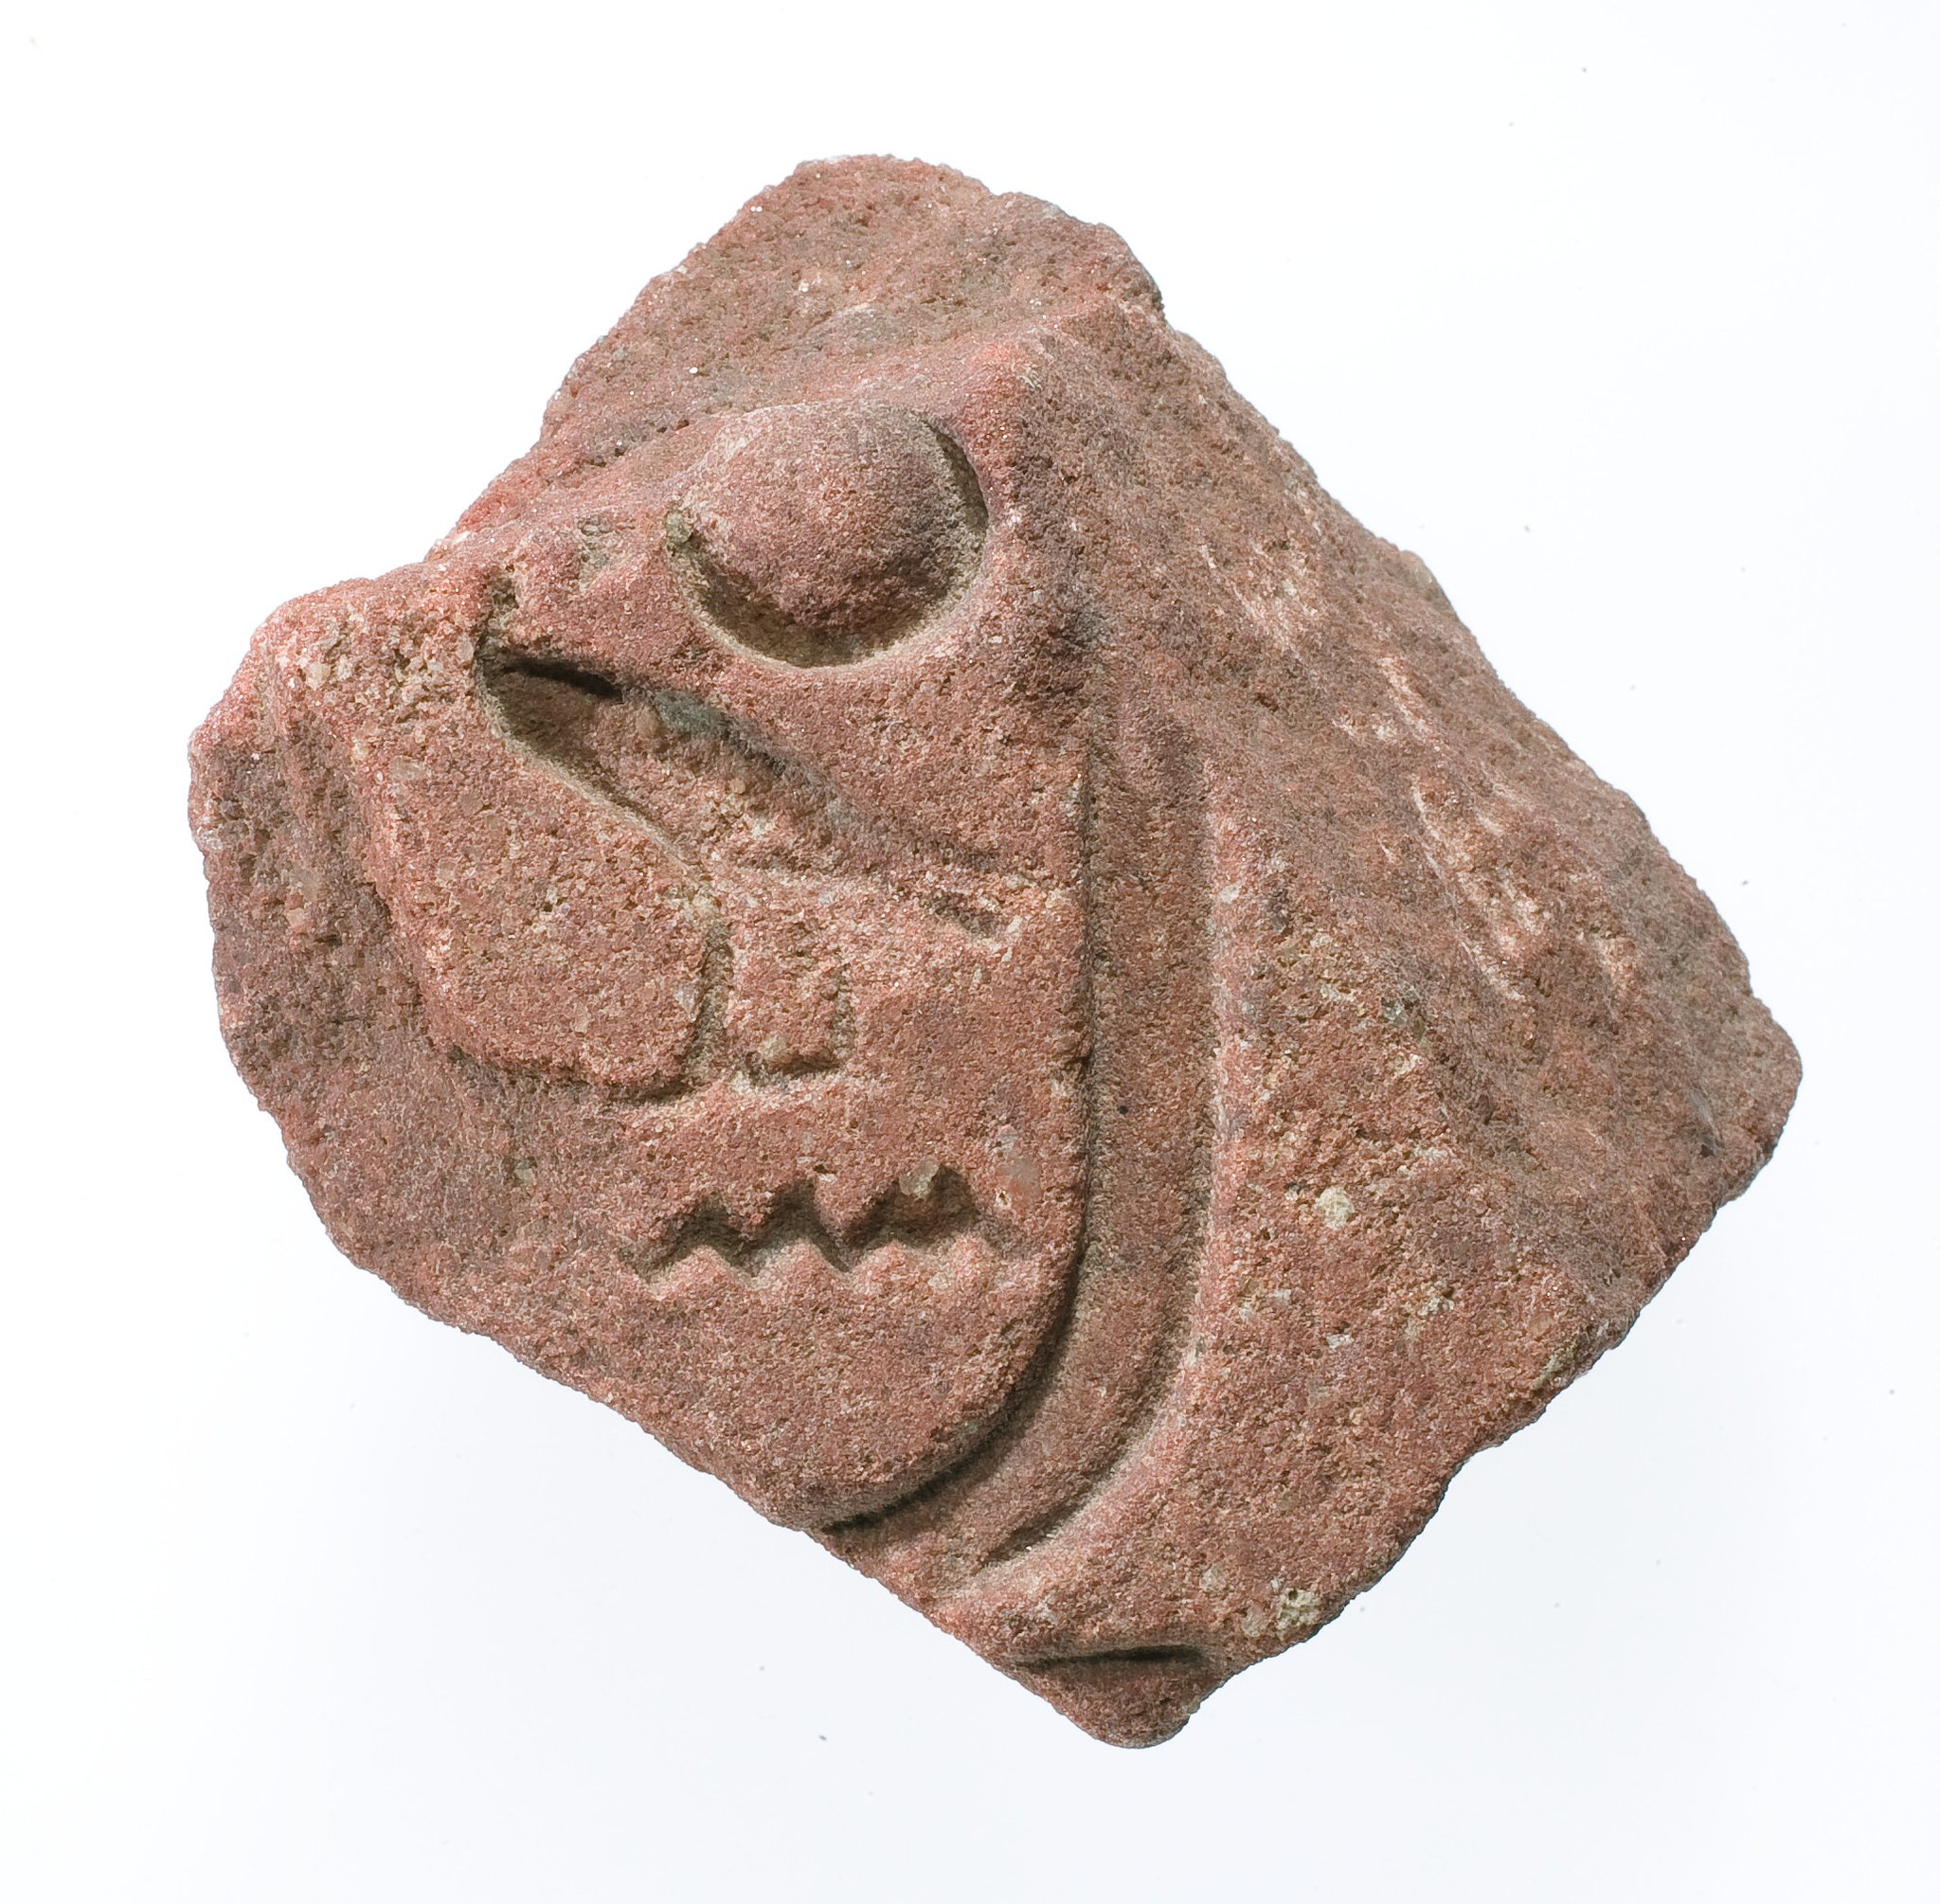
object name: cartouche of akhenaten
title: Fragment with the cartouche of Akhenaten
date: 1353-1336 BCE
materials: quartzite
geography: egypt